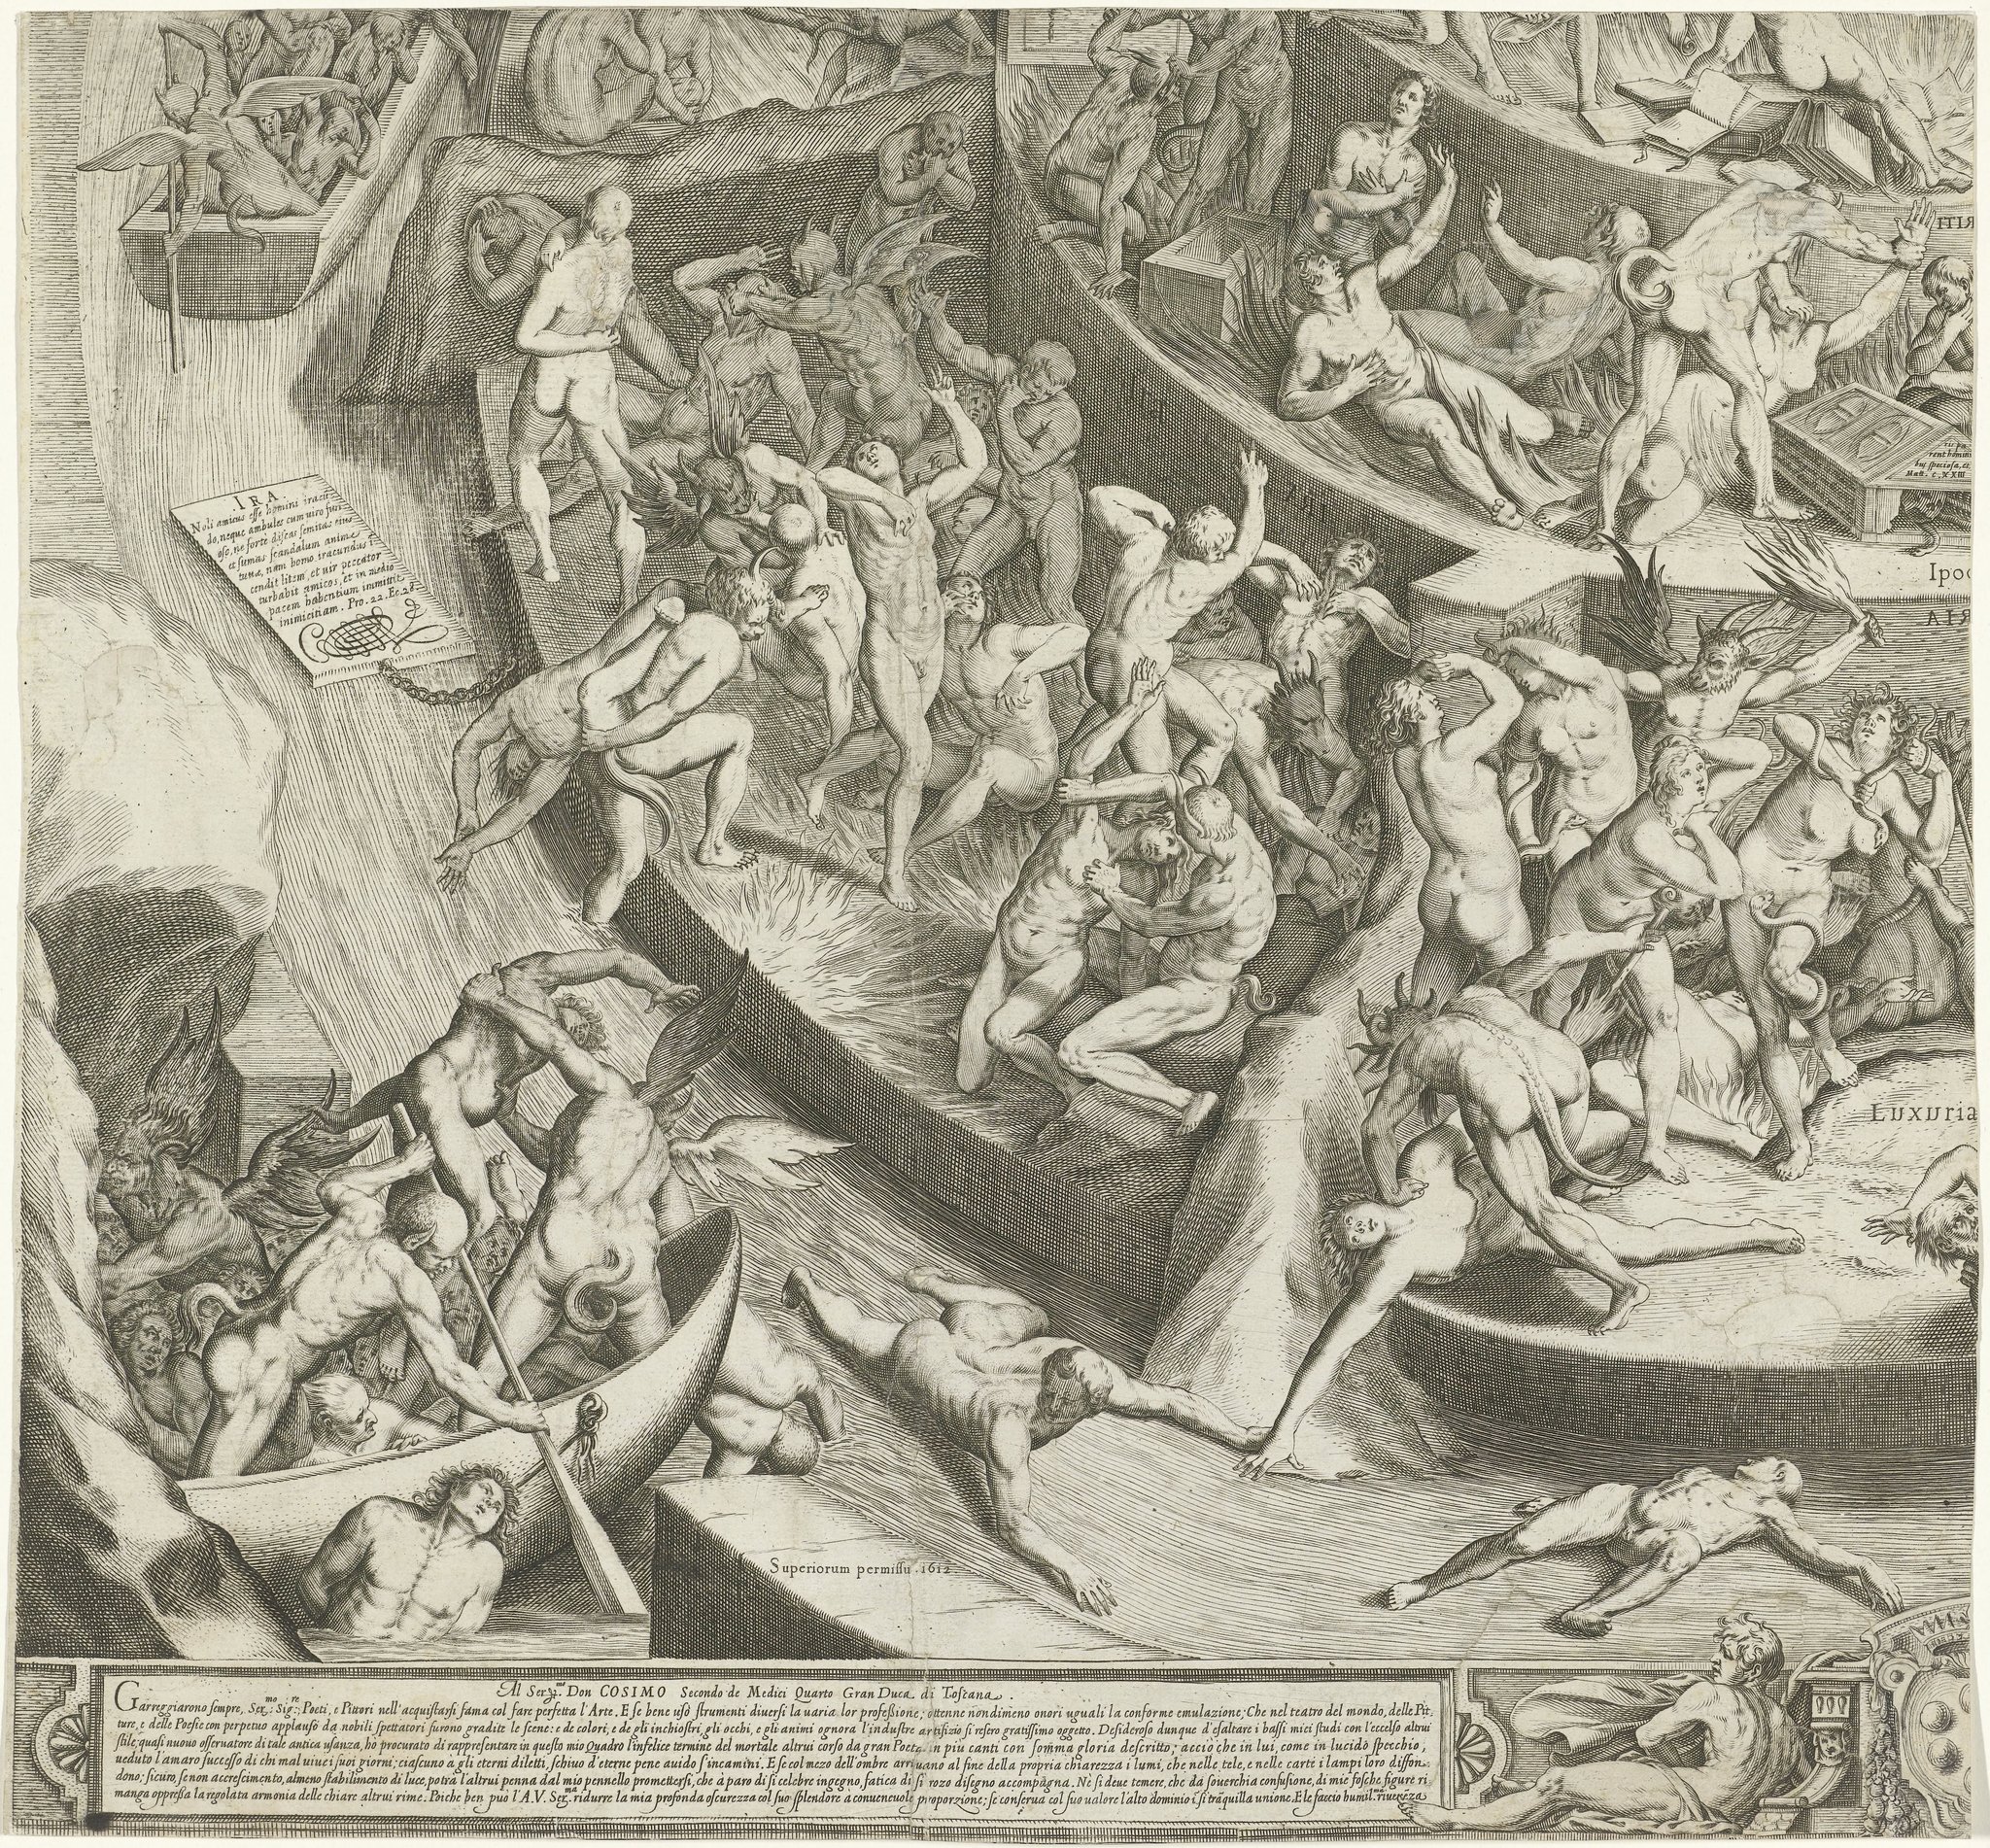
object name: print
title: Hel en vagevuur (deel linksonder)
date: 1612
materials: paper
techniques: engraving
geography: florence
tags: cosimo ii de' medici, vice, and the seven deadly sins, hell divided into compartments, armorial bearing, heraldry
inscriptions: collector's mark: Lugt 240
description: Vierde deel (linksonder) van een voorstelling van de hel als een omheinde, trapsgewijs opgebouwde piramide, met helemaal bovenaan Satan die zielen van zondaars verslindt, en op de lagen onder hem vele verdoemden die door duivelse wezens en vuurhaarden gepijnigd worden. In de hoek linksonder buiten de piramide: duivels die per boot nieuwe zielen aanvoeren. Her en der in de voorstelling verklarende teksten in het Latijn, o.a. van verschillende zonden. Onder de voorstelling (een deel van) het wapen van de Medici en een omkaderde tekst in het Italiaans.